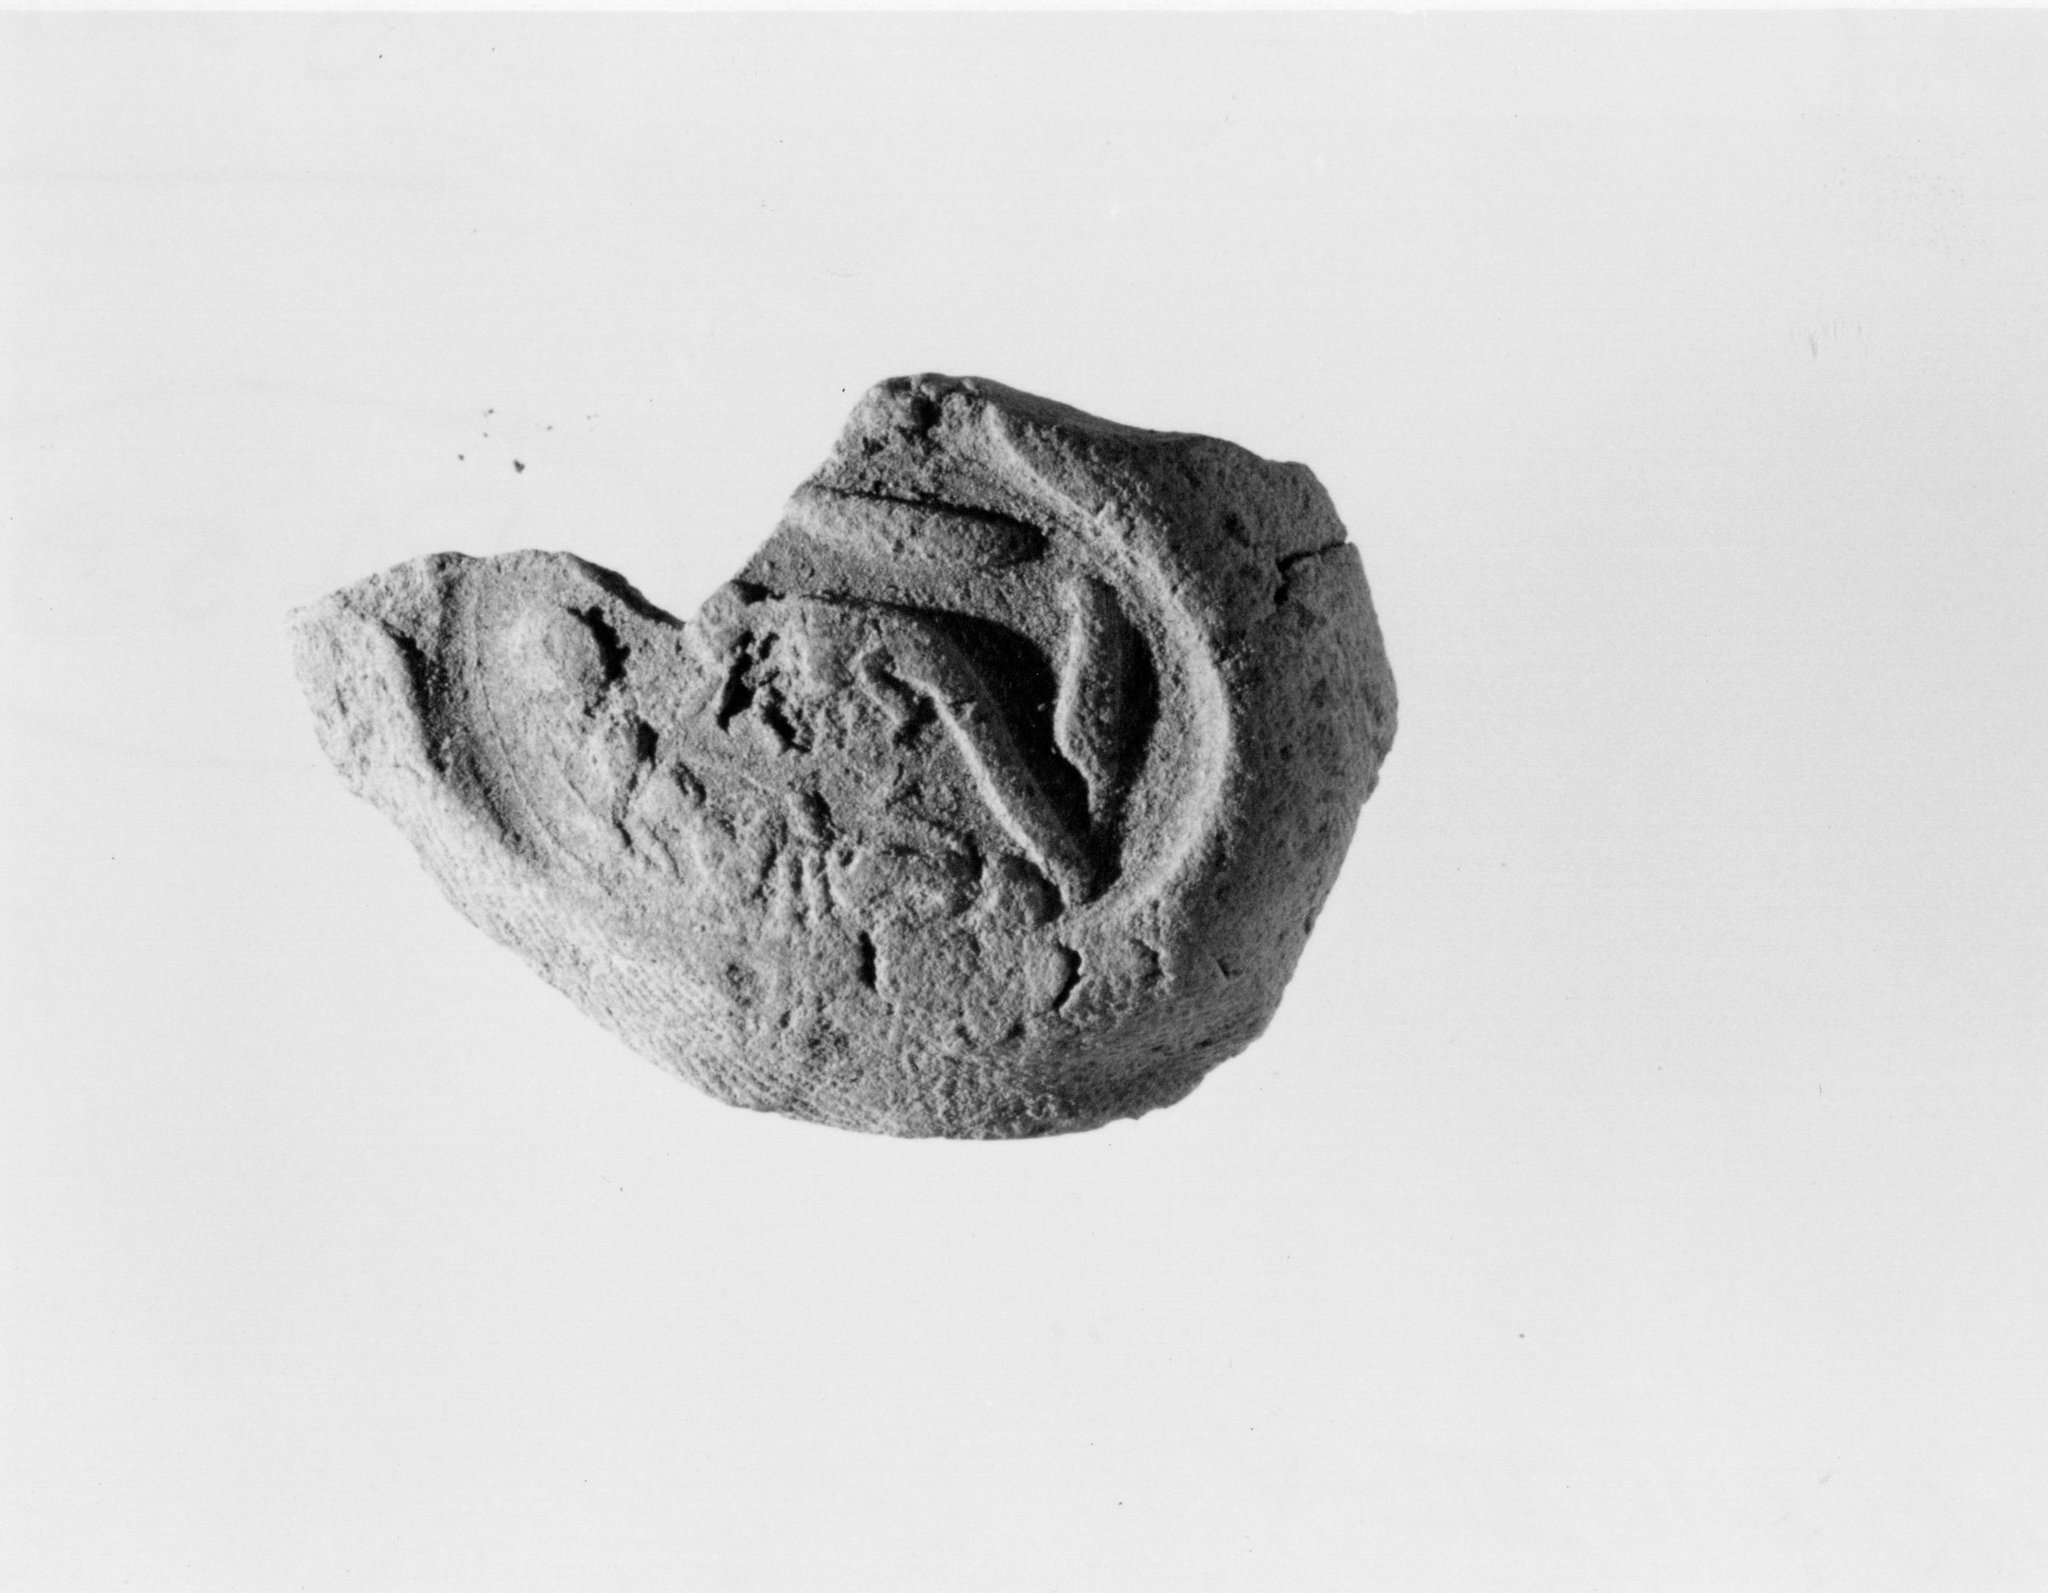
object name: sealing, nebmaatre, amenhotep iii, heb sed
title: Document Sealing With the Throne Name of Amenhotep III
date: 1390-1352 BCE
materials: mud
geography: egypt